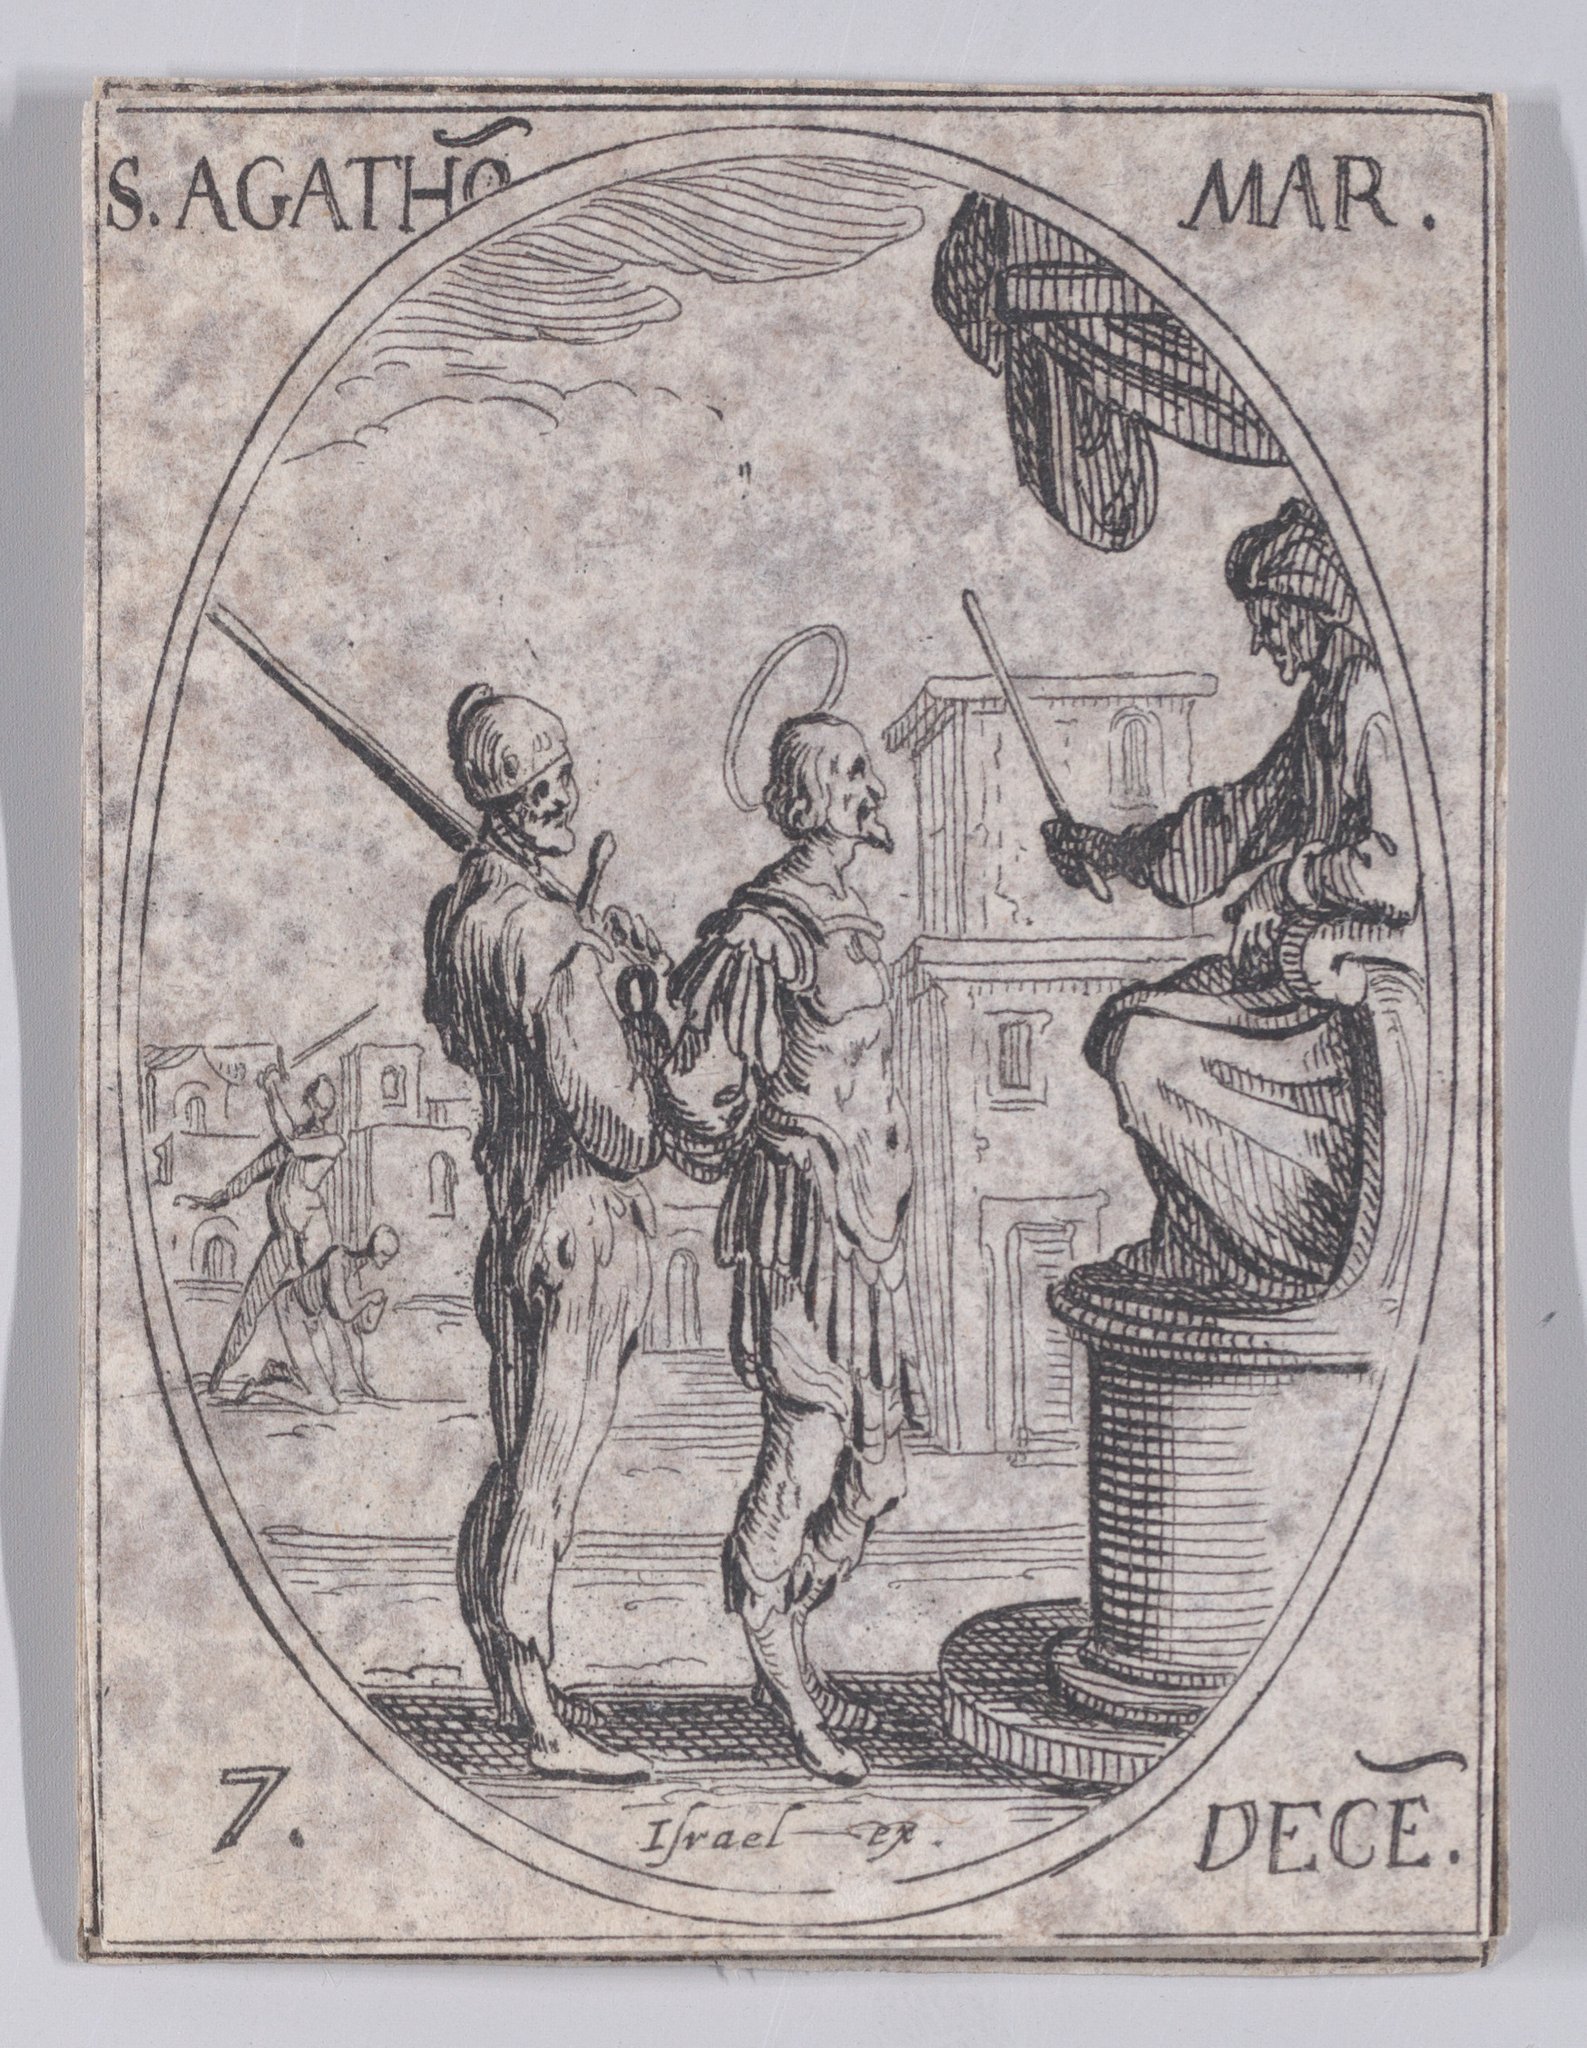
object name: print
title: St. Agathon, Martyr, December 7th, from "Les Images De Tous Les Saincts et Saintes de L'Année" (Images of All of the Saints and Religious Events of the Year)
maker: jacques callot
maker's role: artist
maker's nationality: french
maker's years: 1592-1635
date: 1636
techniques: etching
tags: men,saints